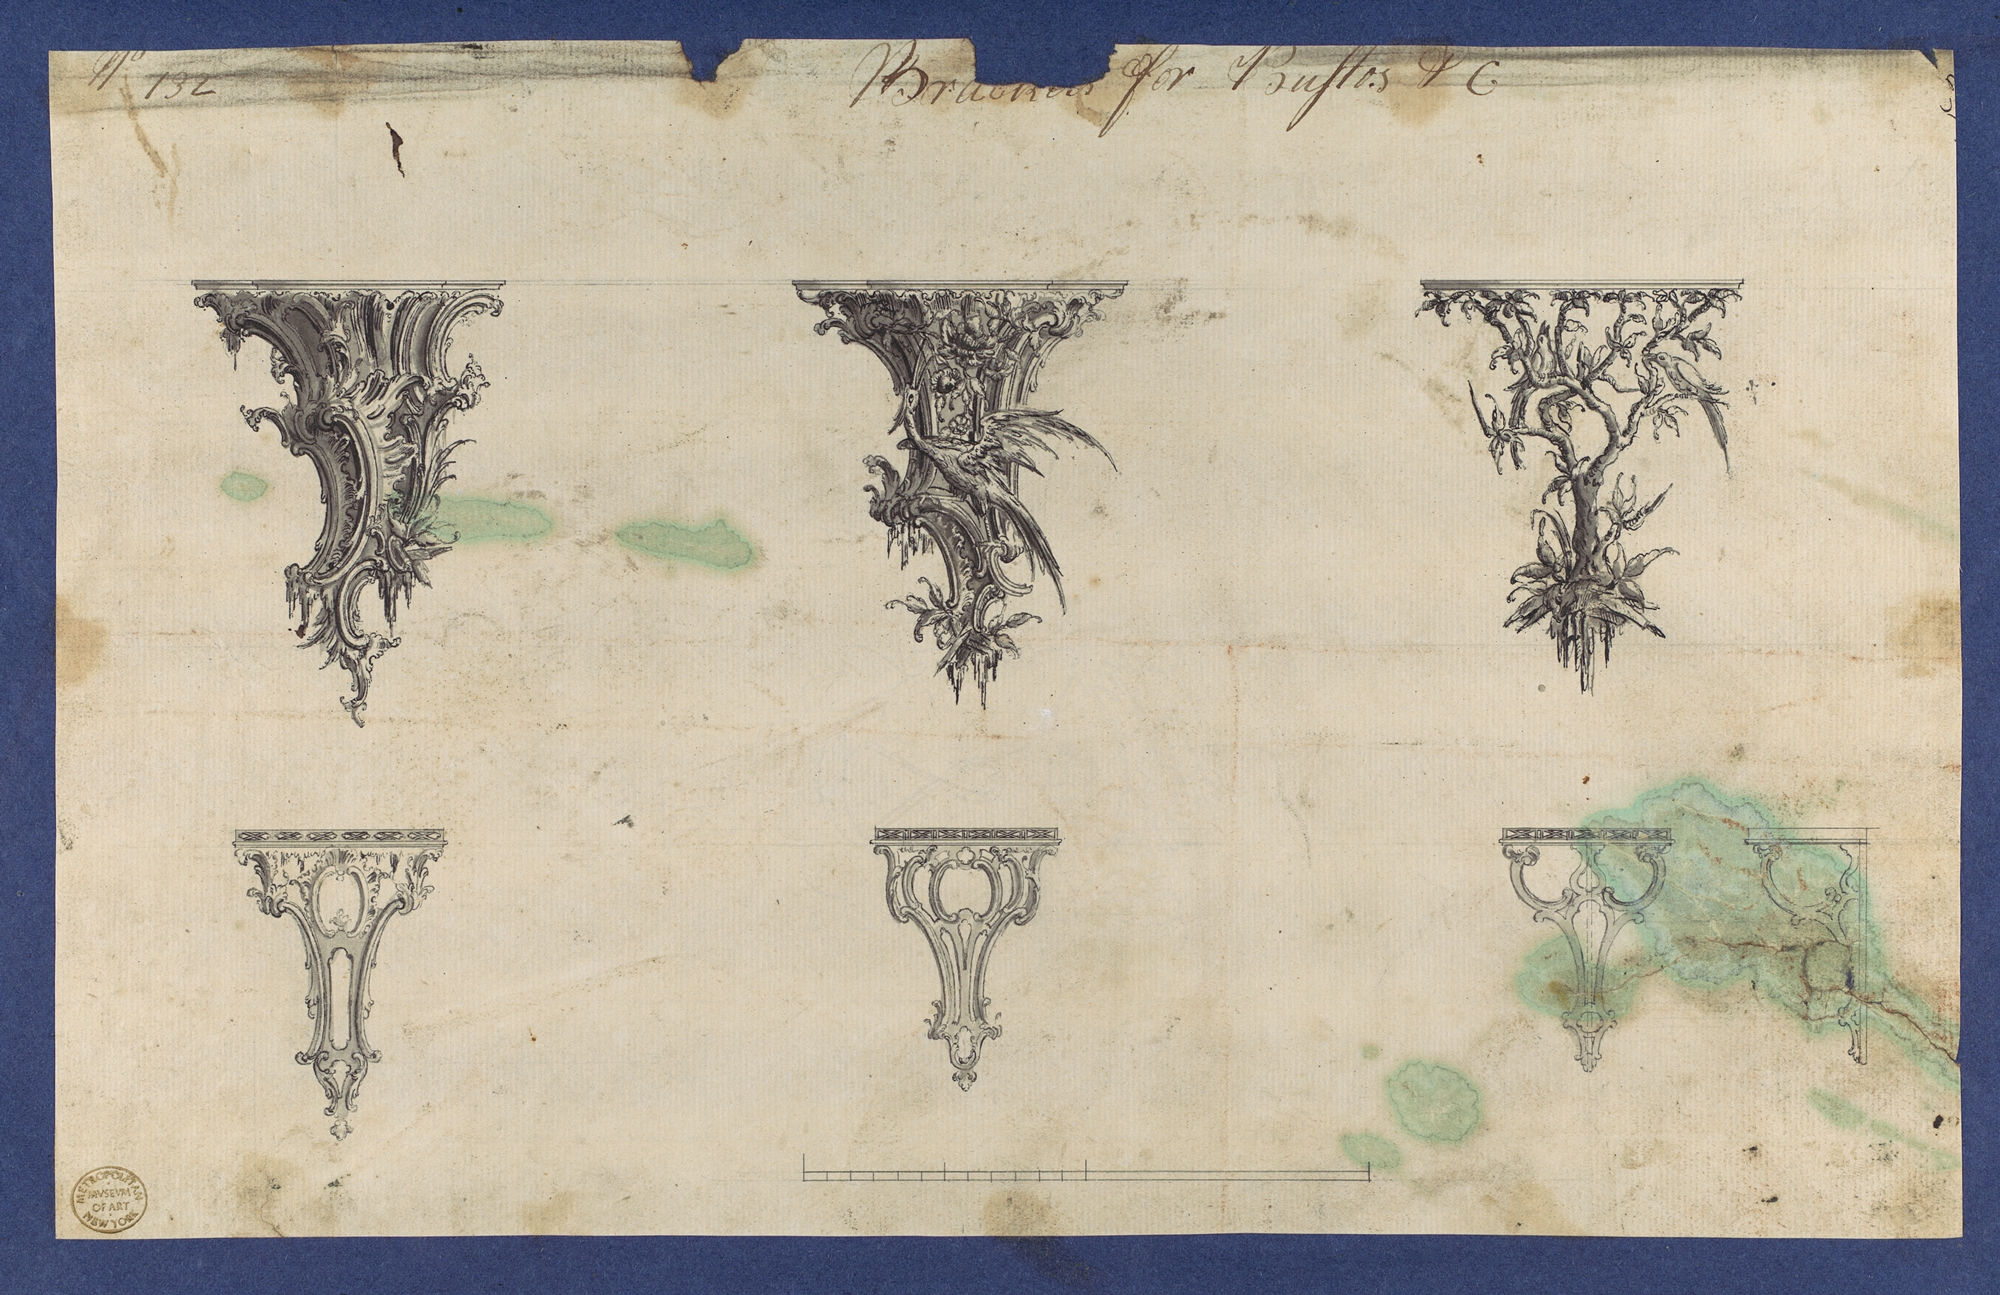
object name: drawing ornament architecture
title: Brackets for Bustos, in Chippendale Drawings, Vol. I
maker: thomas chippendale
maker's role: artist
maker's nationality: british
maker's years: 1718-1779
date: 1754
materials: ink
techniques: wash